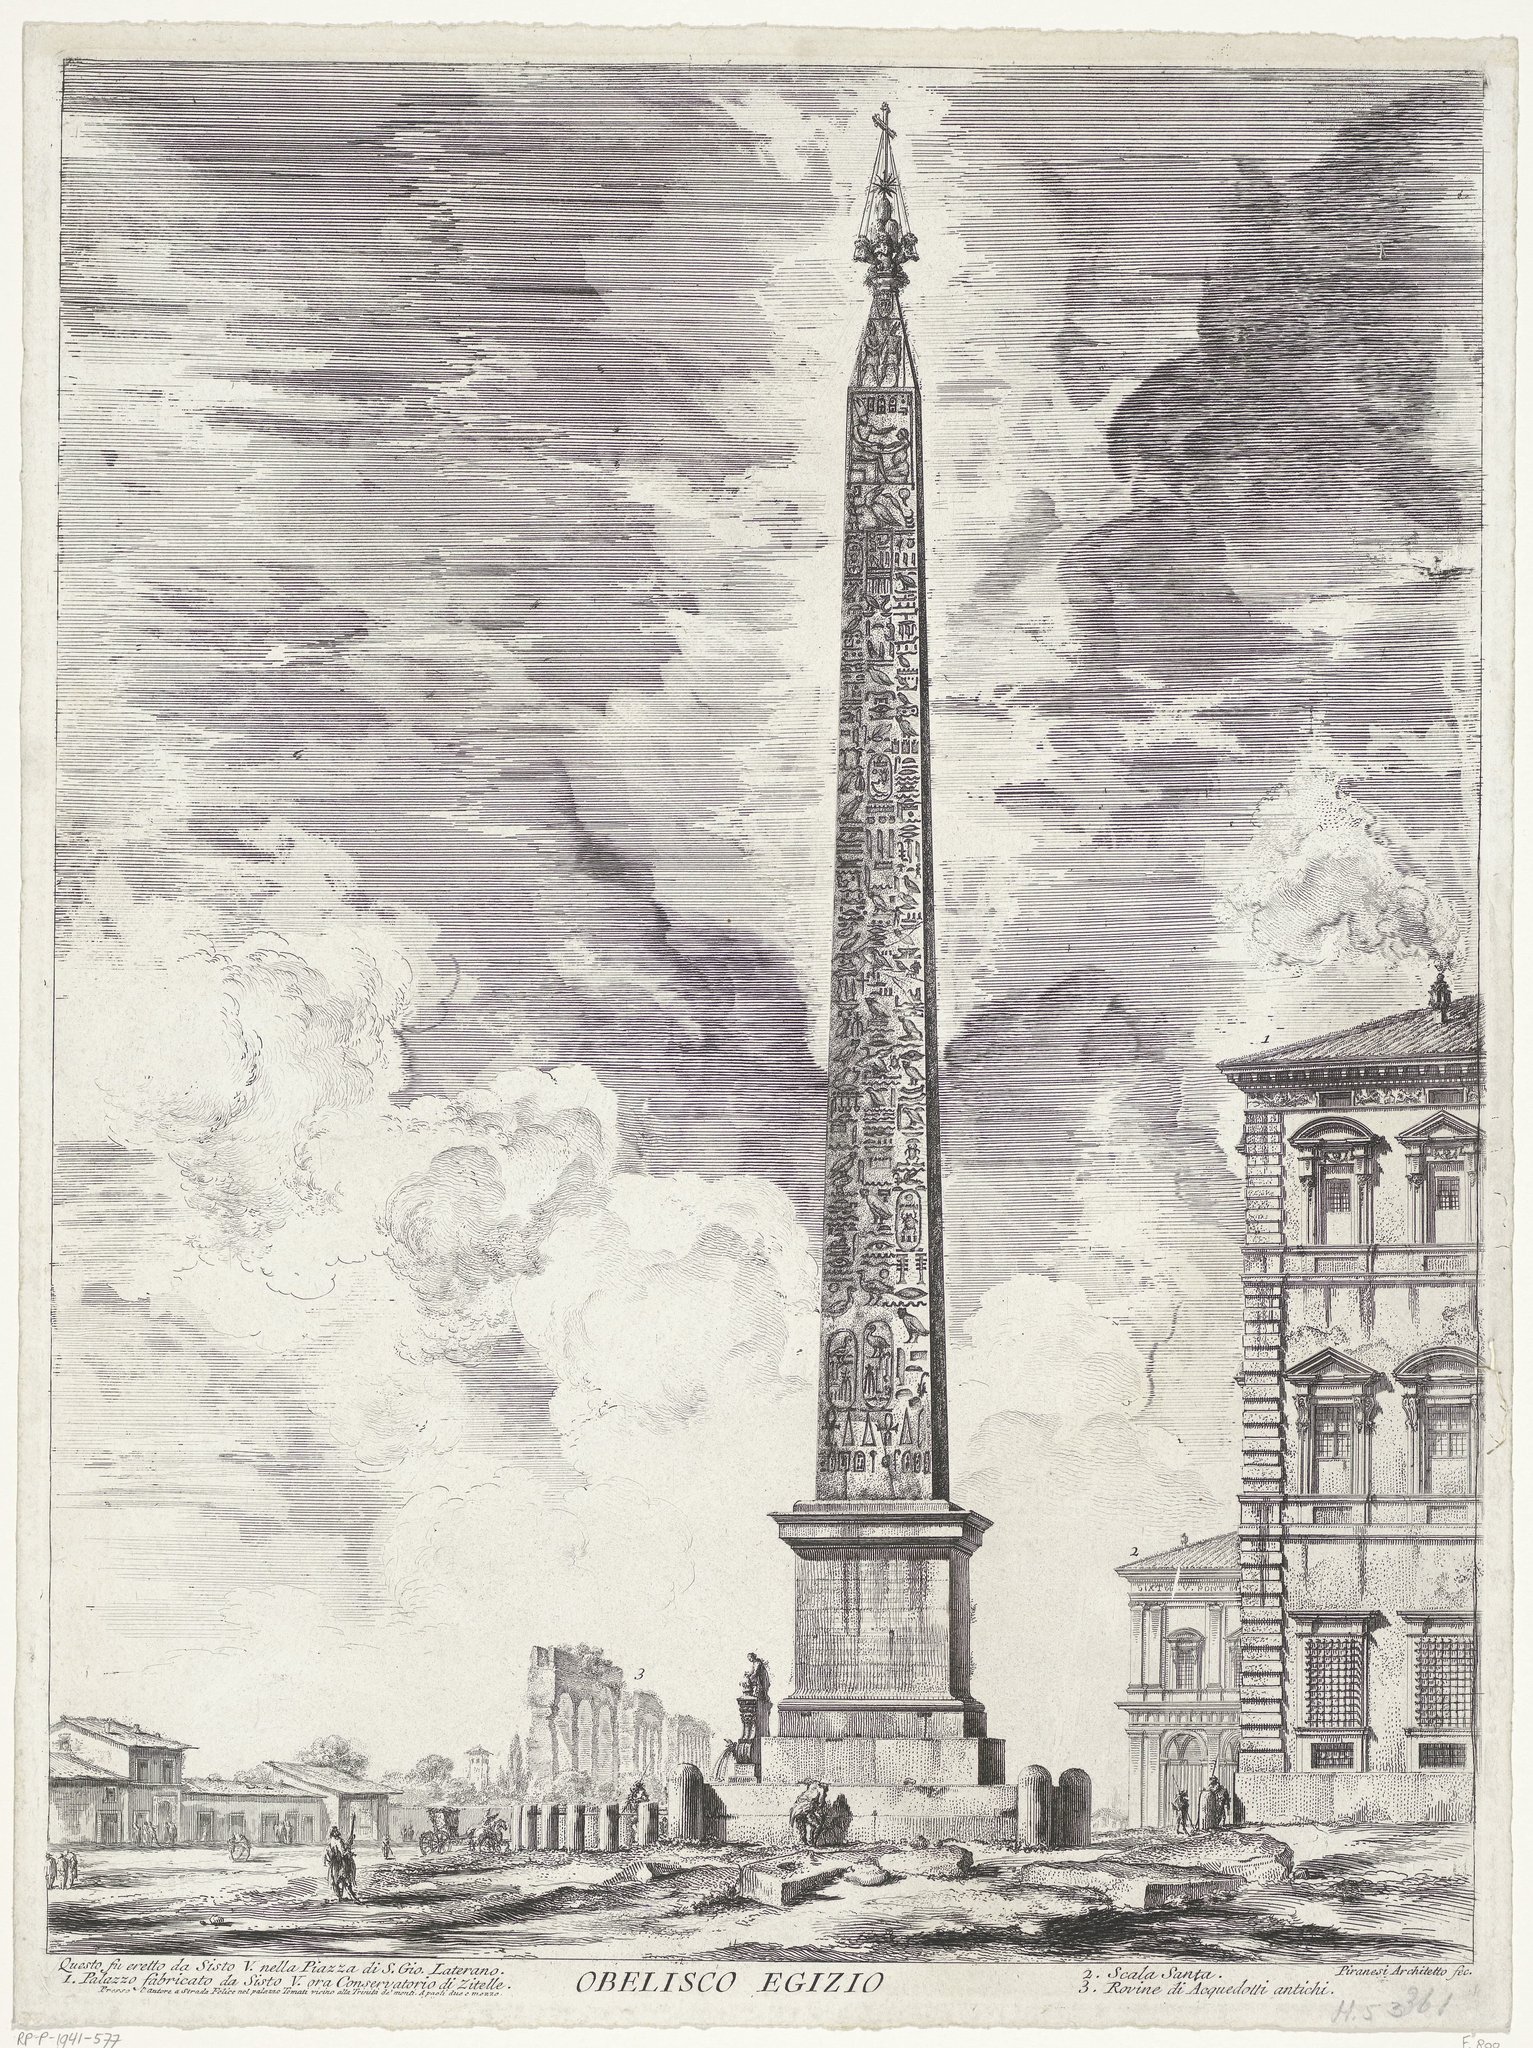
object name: print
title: Lateraanse Obelisk te Rome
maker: giovanni battista piranesi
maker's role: designer, draughtsman, print maker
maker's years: 1720-1778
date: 1748-1778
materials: paper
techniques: etching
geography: rome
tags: square, place, circus, etc., obelisk, needle, church (exterior), rome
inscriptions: collector's mark: Lugt 2228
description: Deze prent maakt deel uit van de serie 'Vedute di Roma'. Piranesi werkte aan deze 135 platen tellende serie tussen 1748 en zijn dood in 1778. Francesco Piranesi voegde later nog twee prenten toe aan de reeks van zijn vader.